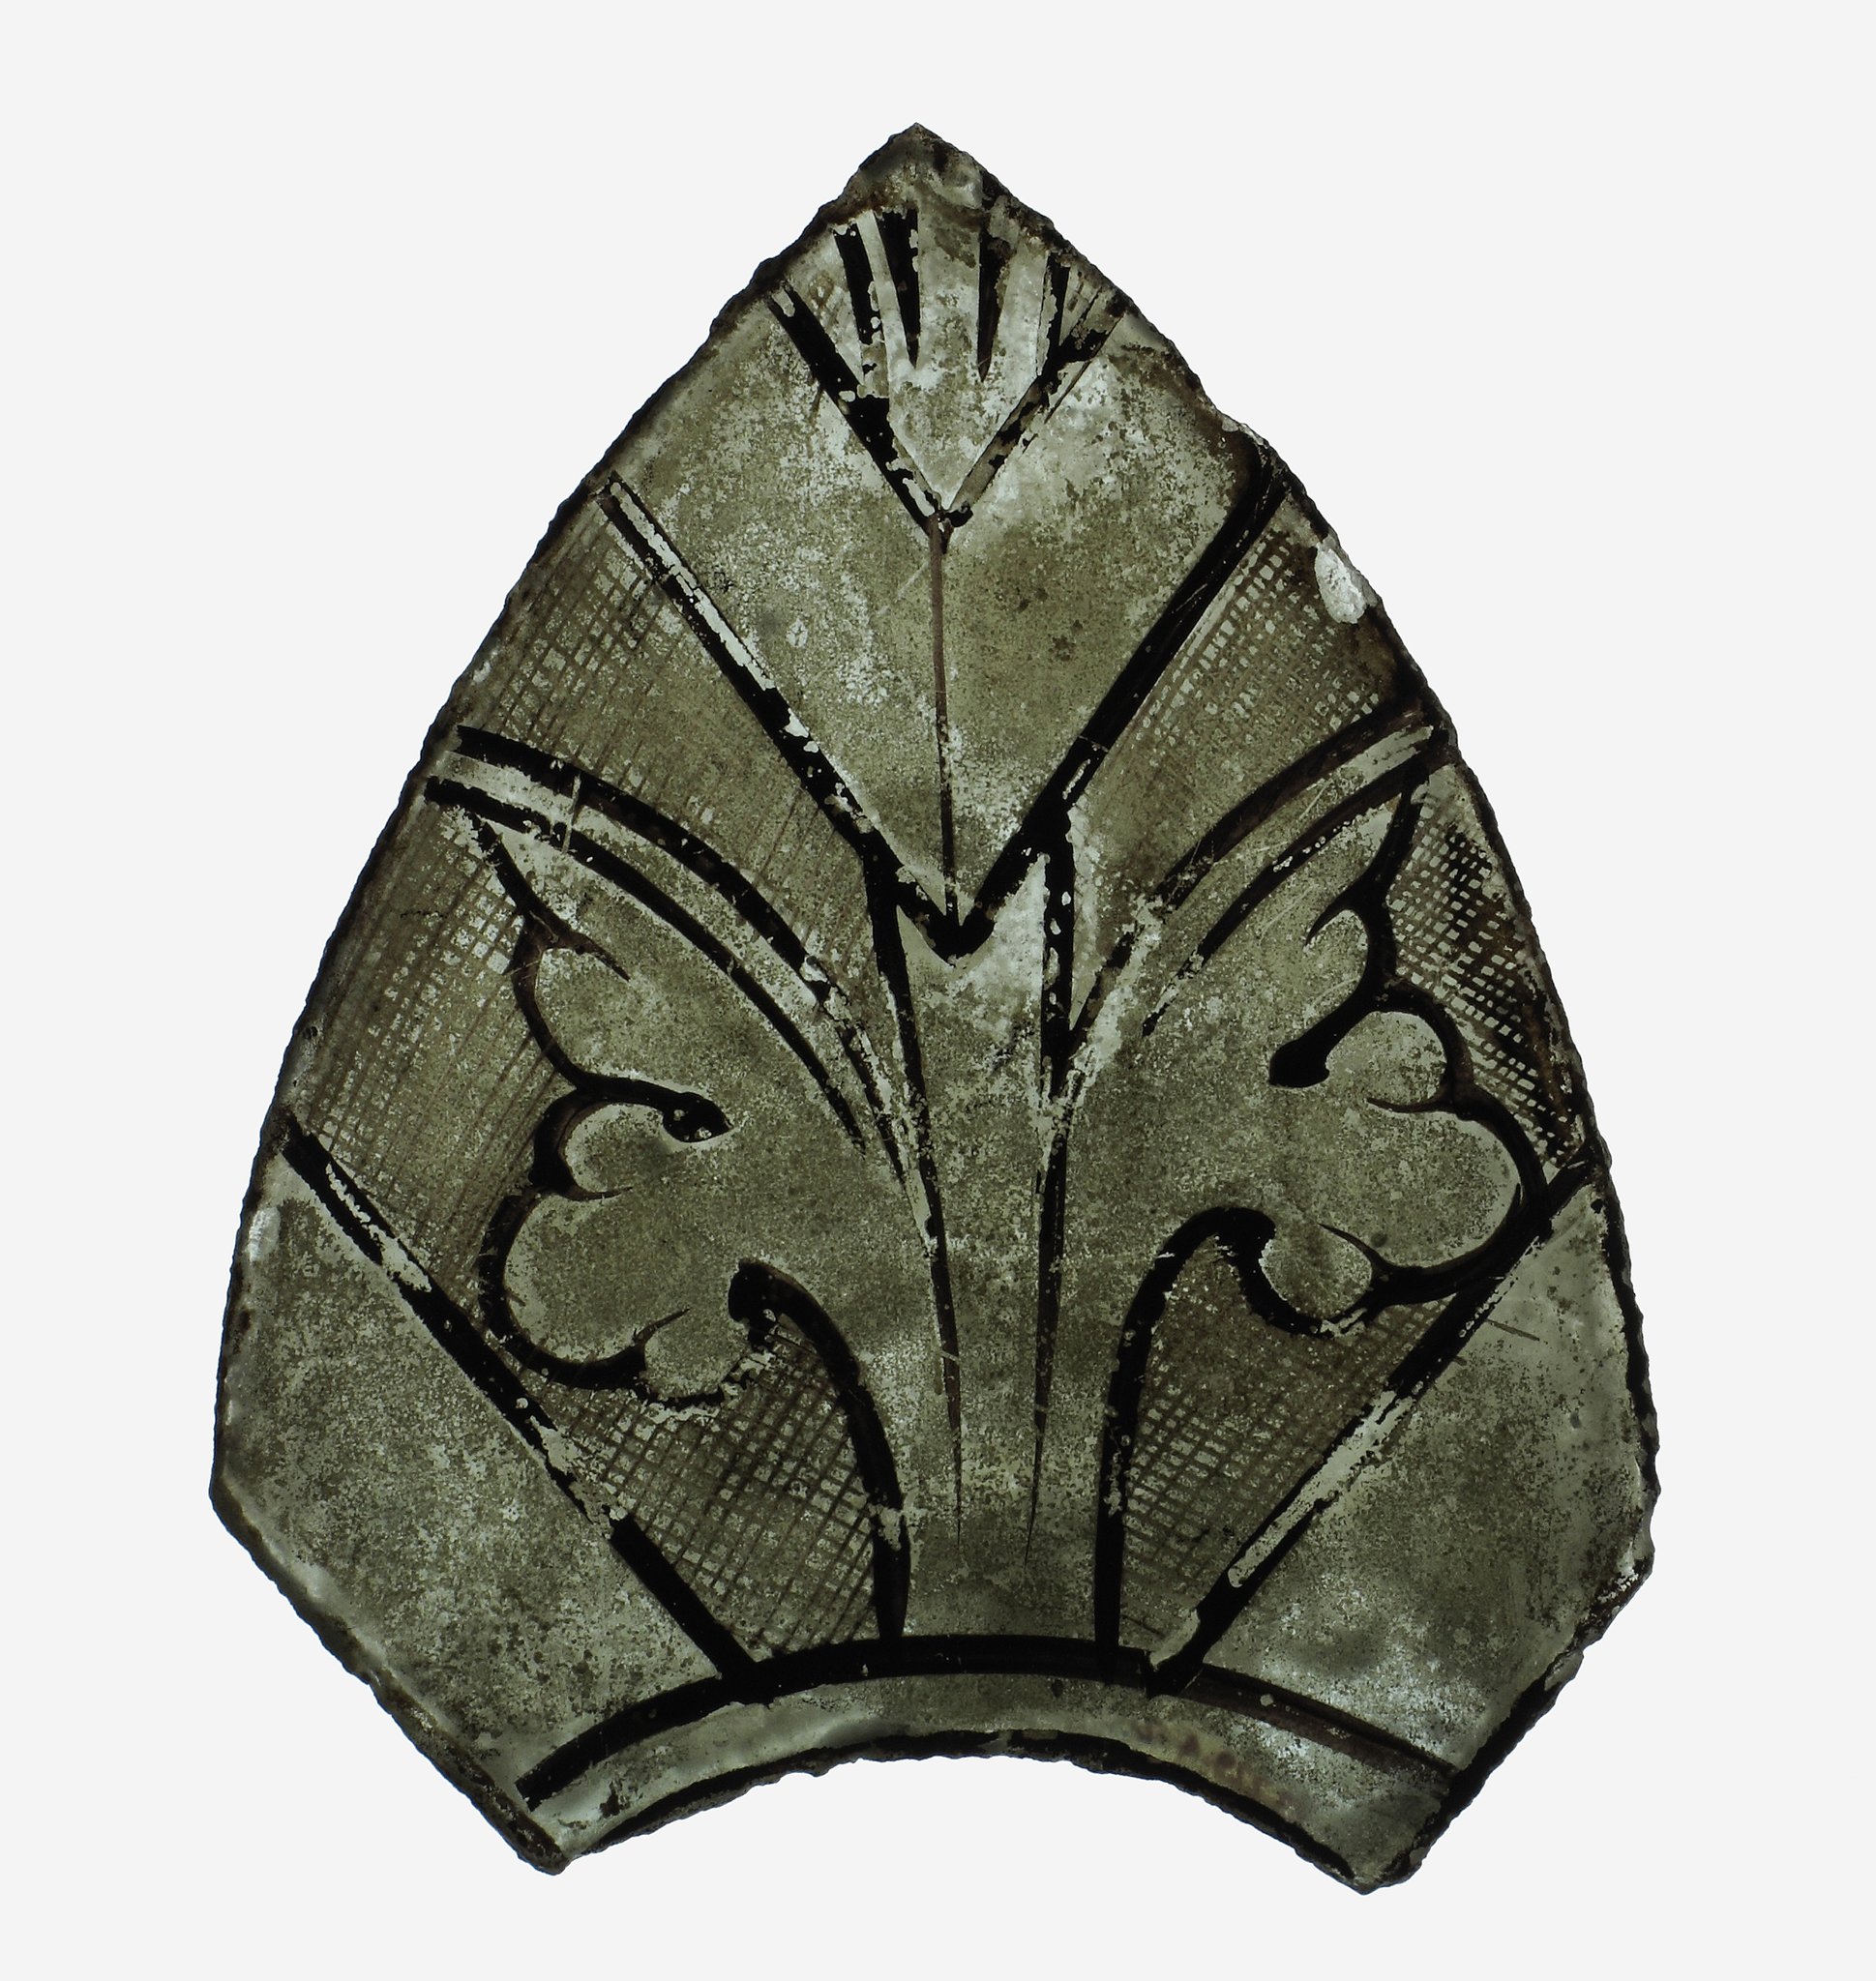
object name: fragment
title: Glass Fragment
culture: french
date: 1201-1300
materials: glass